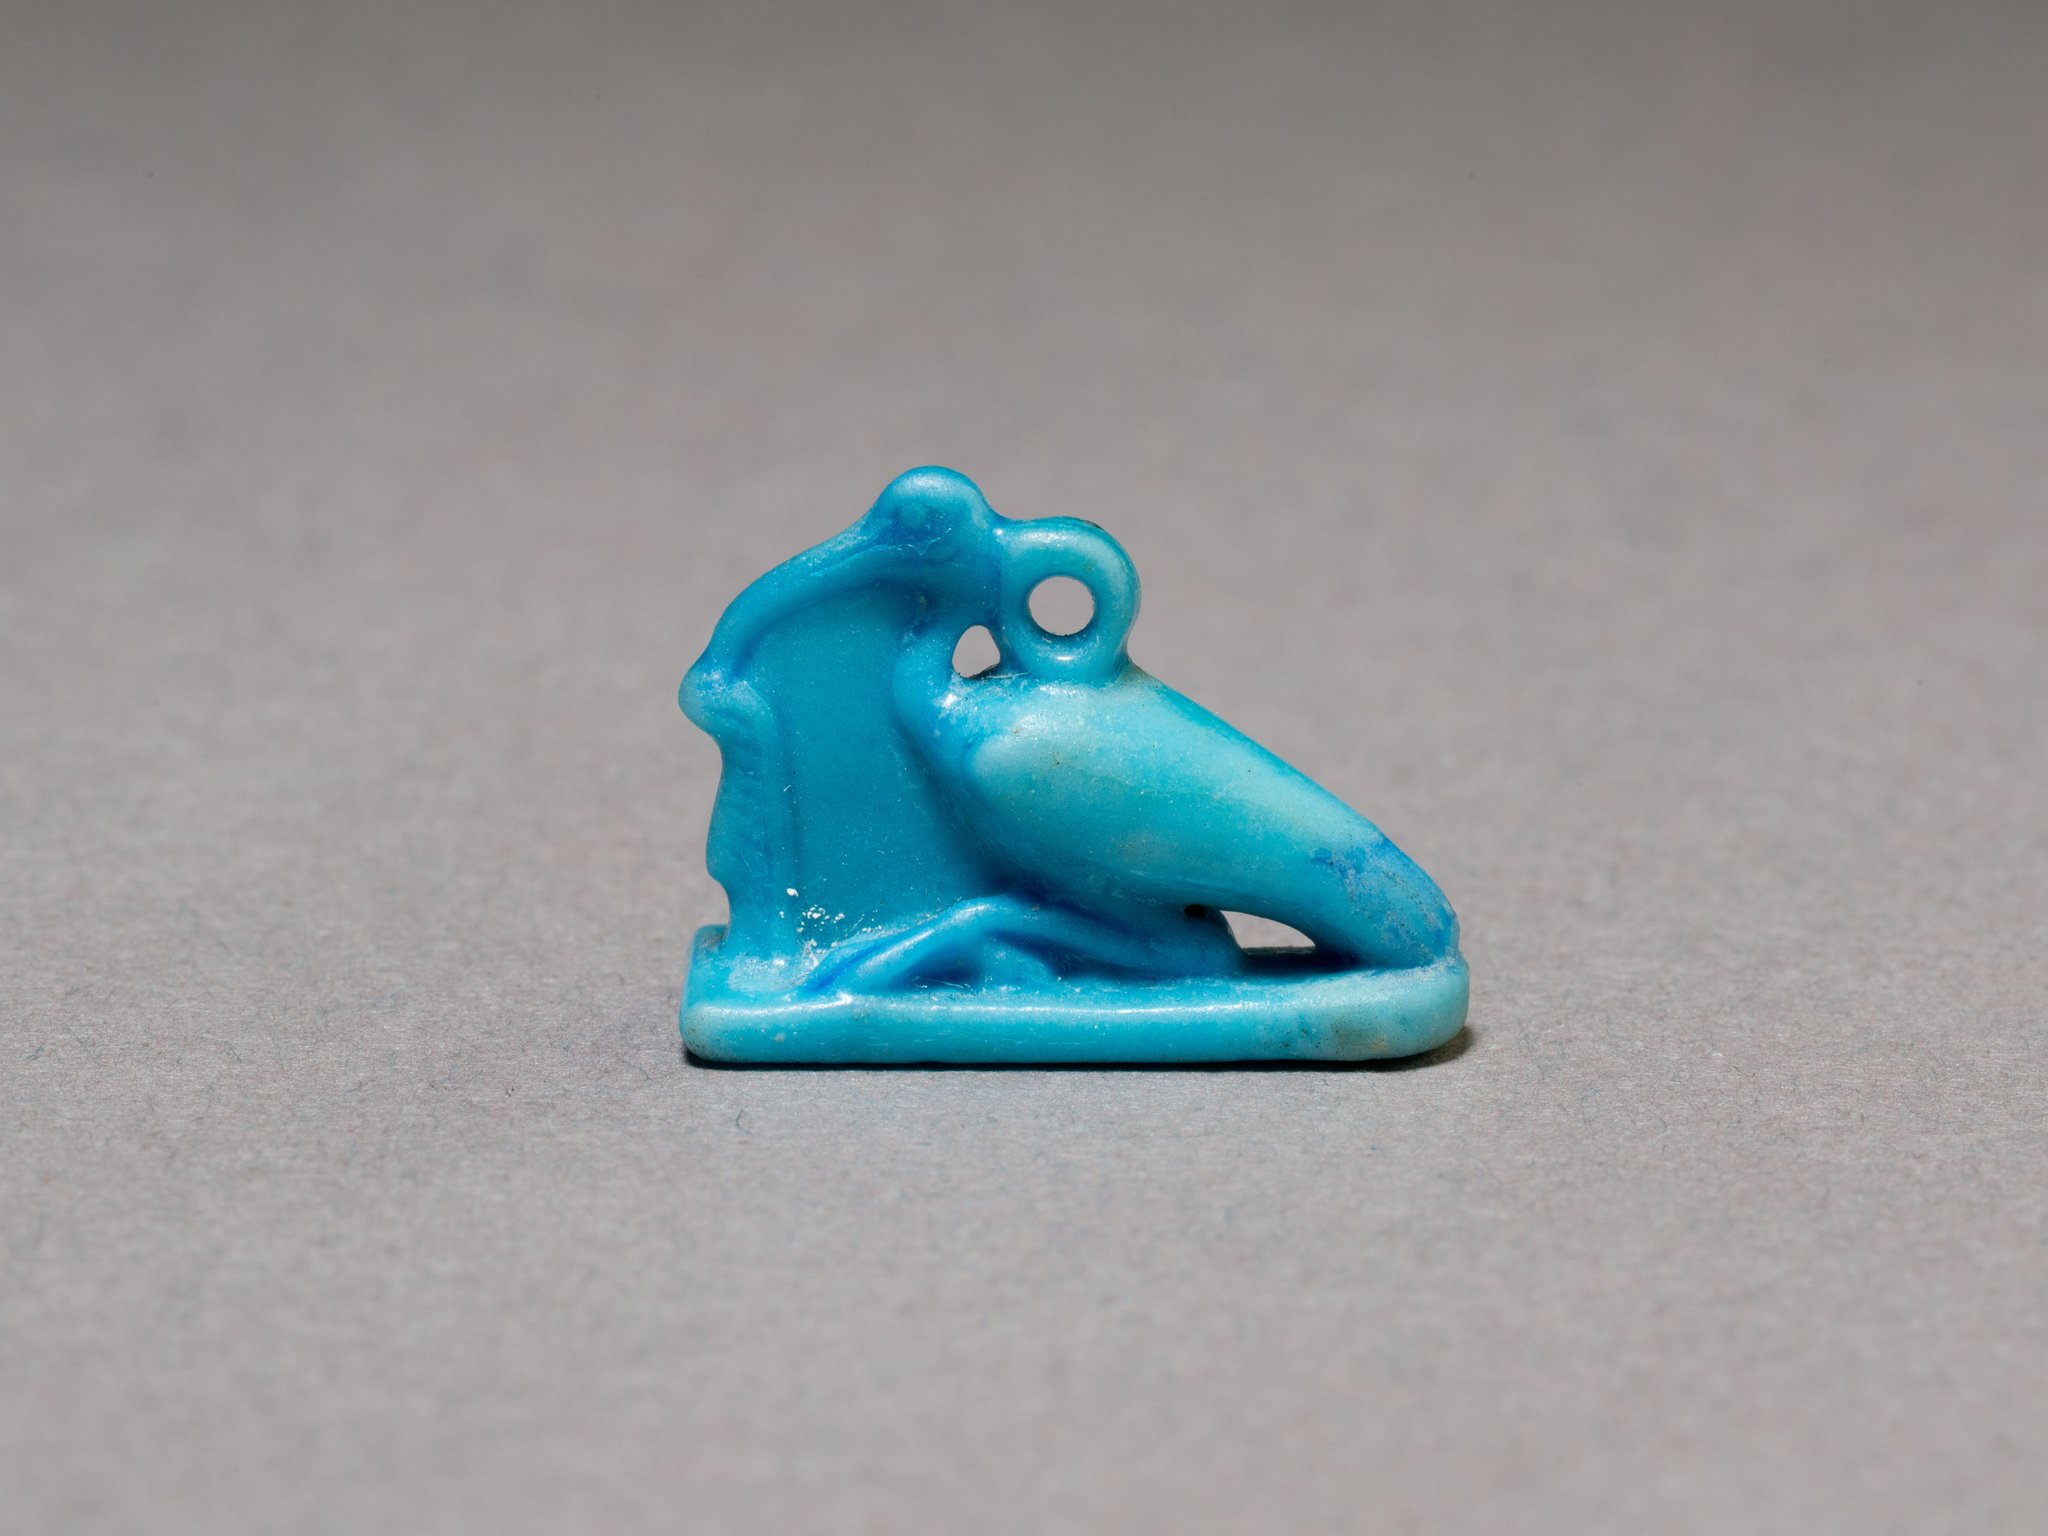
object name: amulet, ibis, maat feather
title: Ibis with maat feather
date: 664-630 BCE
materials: faience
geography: egypt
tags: birds